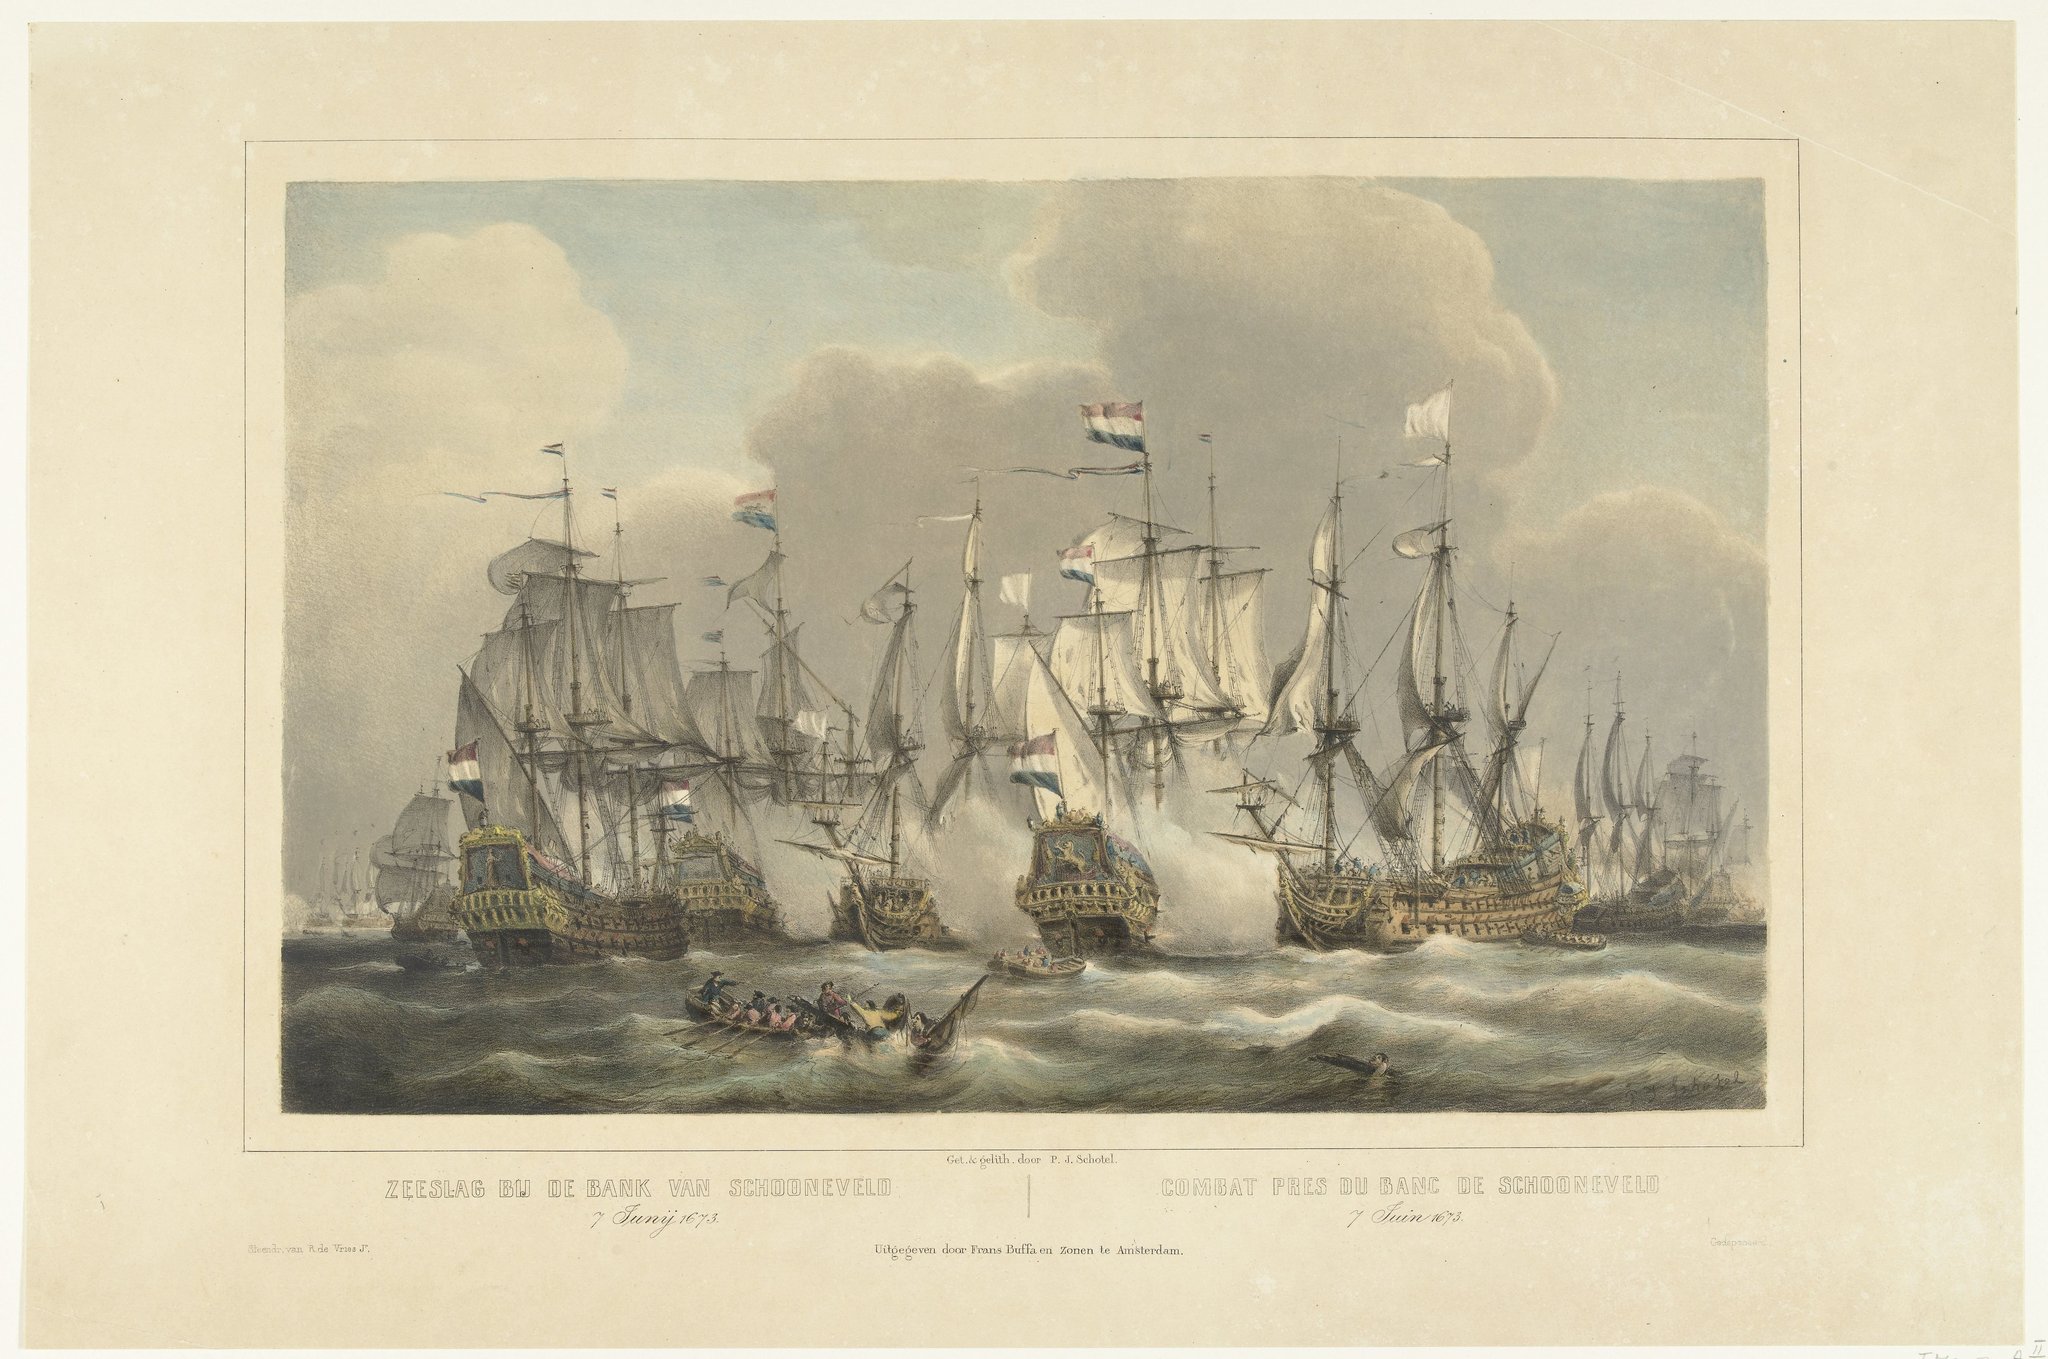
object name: history print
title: Zeeslag op Schoonevelt, 7 juni 1673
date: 1848-1855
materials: paper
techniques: hand coloring, lithograph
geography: amsterdam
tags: prague, london, painter, print maker, draughtsman, prinz ruprecht, flushing, michiel adriaenszoon de ruyter, rotterdam, cornelis tromp, battle (+ naval force), first battle of schooneveld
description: De zeeslag voor de Zeeuwse kust op de vlakte van Schoonevelt op 7 juni 1673 tussen de vloot van de Republiek onder Michiel Adriaenszoon de Ruyter en Cornelis Tromp en de gecombineerde Engels-Franse vloot onder Prins Rupert en graaf Jean d'Estrées.